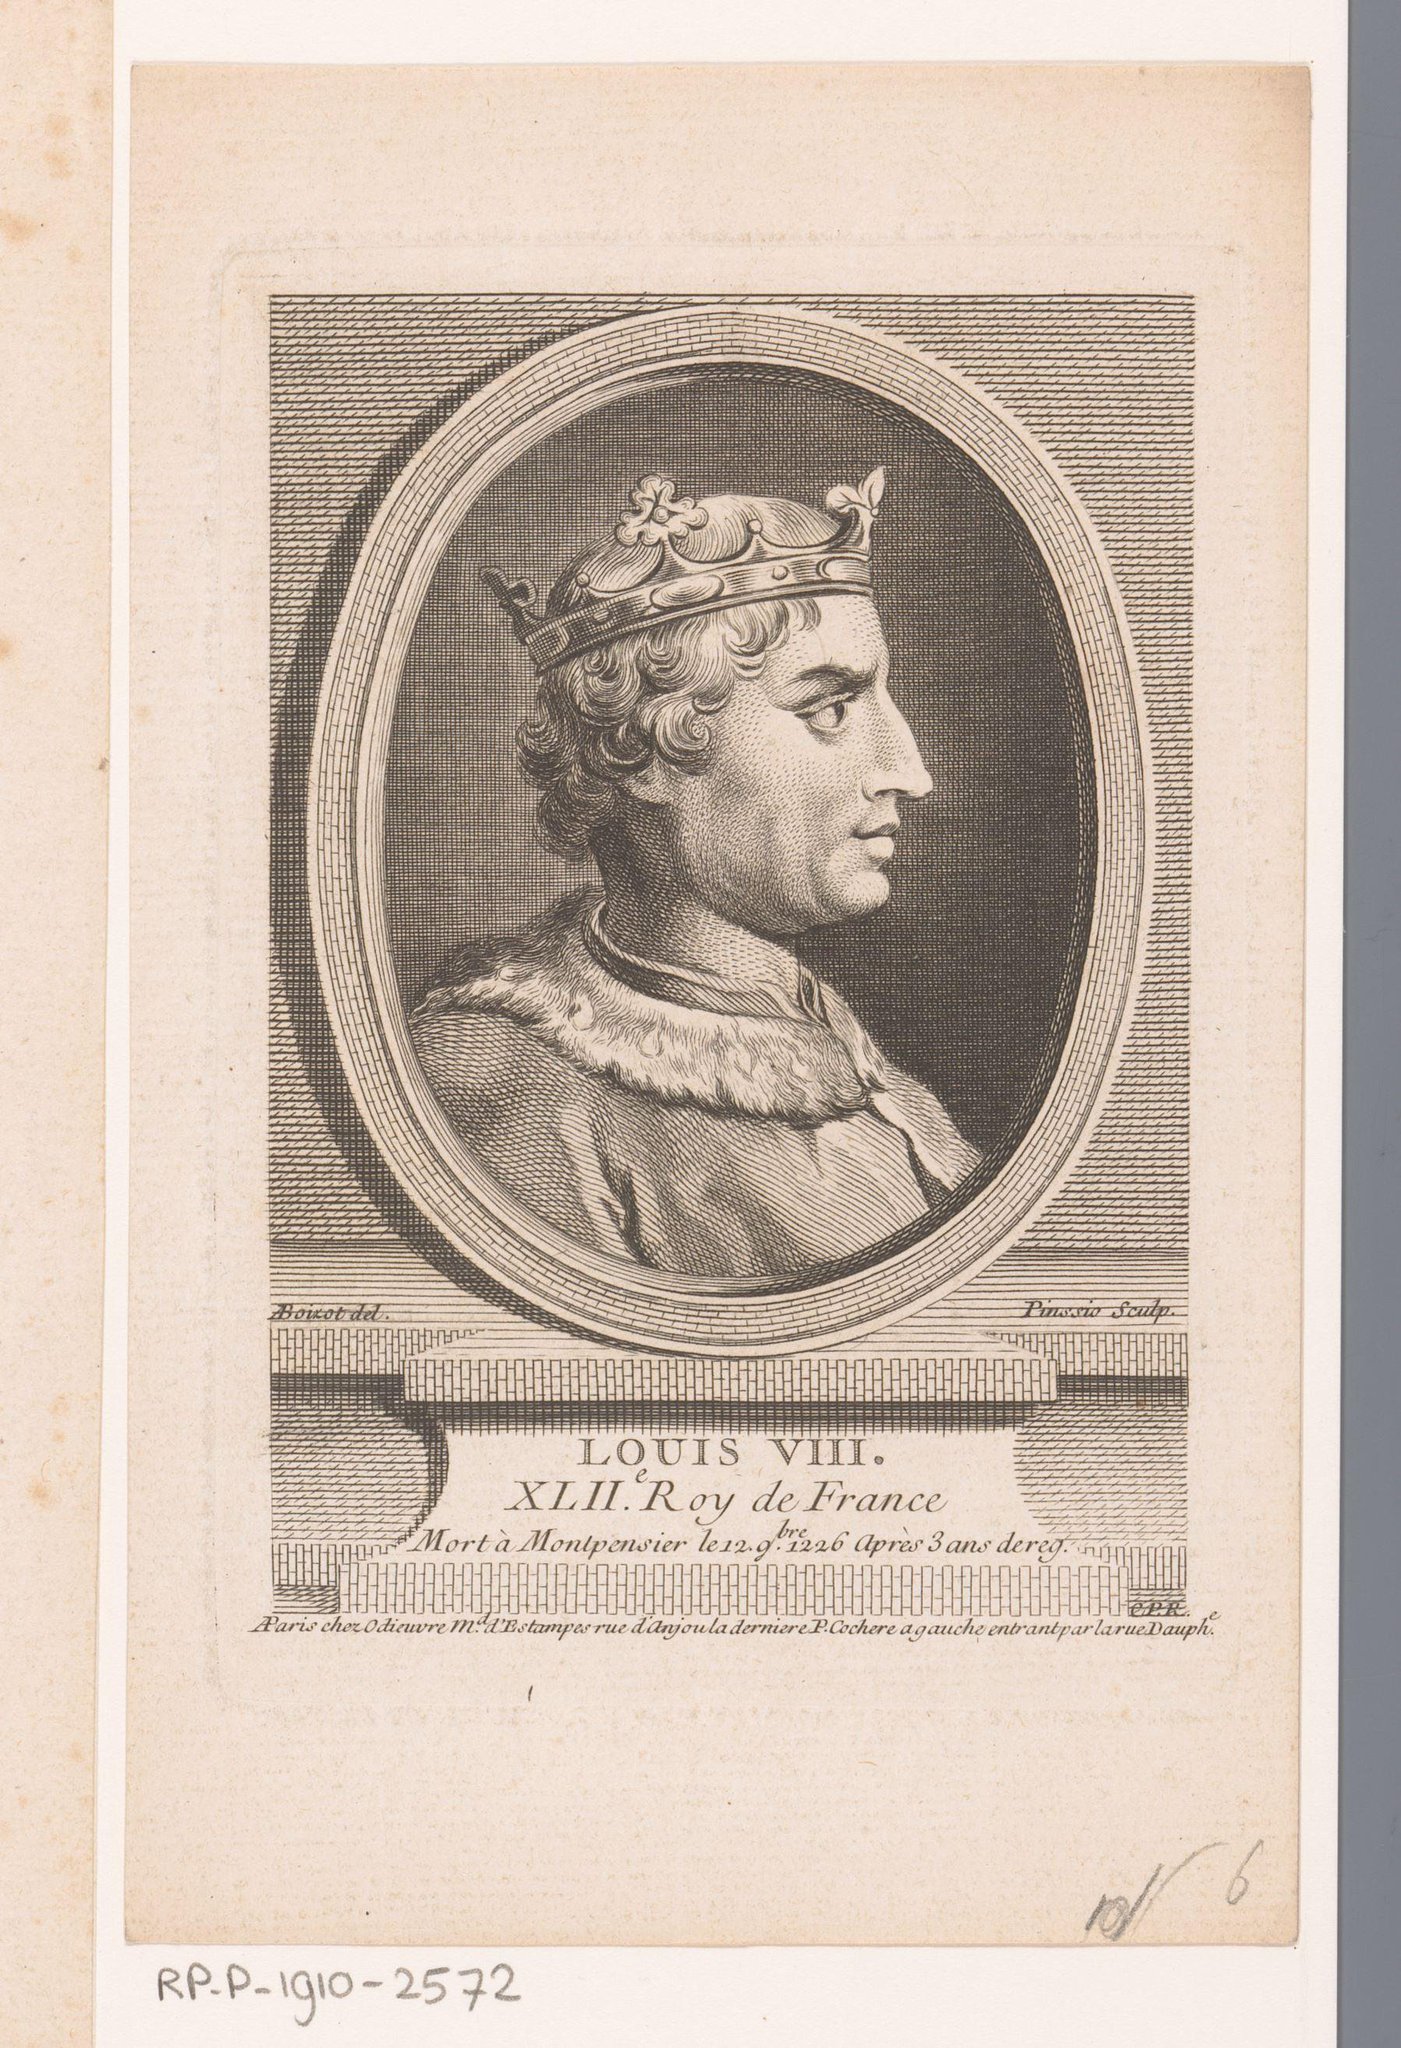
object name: book illustration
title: Portret van Gilles de Maupeou I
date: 1755-1765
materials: paper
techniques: engraving, etching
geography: paris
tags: historical persons, lawyer, attorney at law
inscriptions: collector's mark: Lugt 2228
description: Prent uit: Dreux du Radier, Jean-François. L'Europe illustré, contenant l'histoire abregée des souverains, des princes, des prélats, des ministres, (...) en Europe: dans le XVe. siècle compris, jusqu'à présent. Parijs: Michel Odieuvre en André-François Le Breton, 1755-1765.